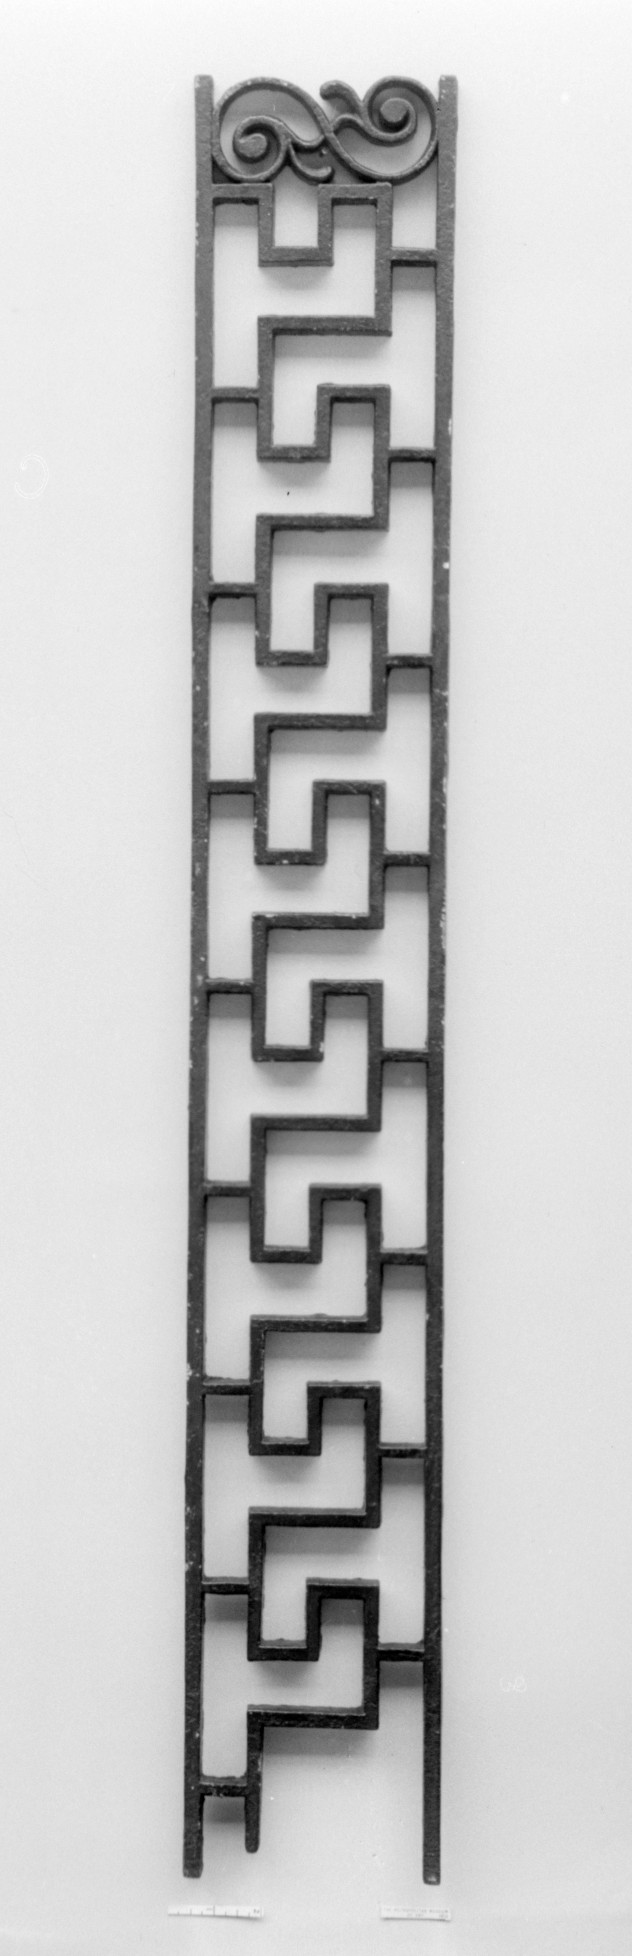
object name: baluster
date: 1767-1833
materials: iron